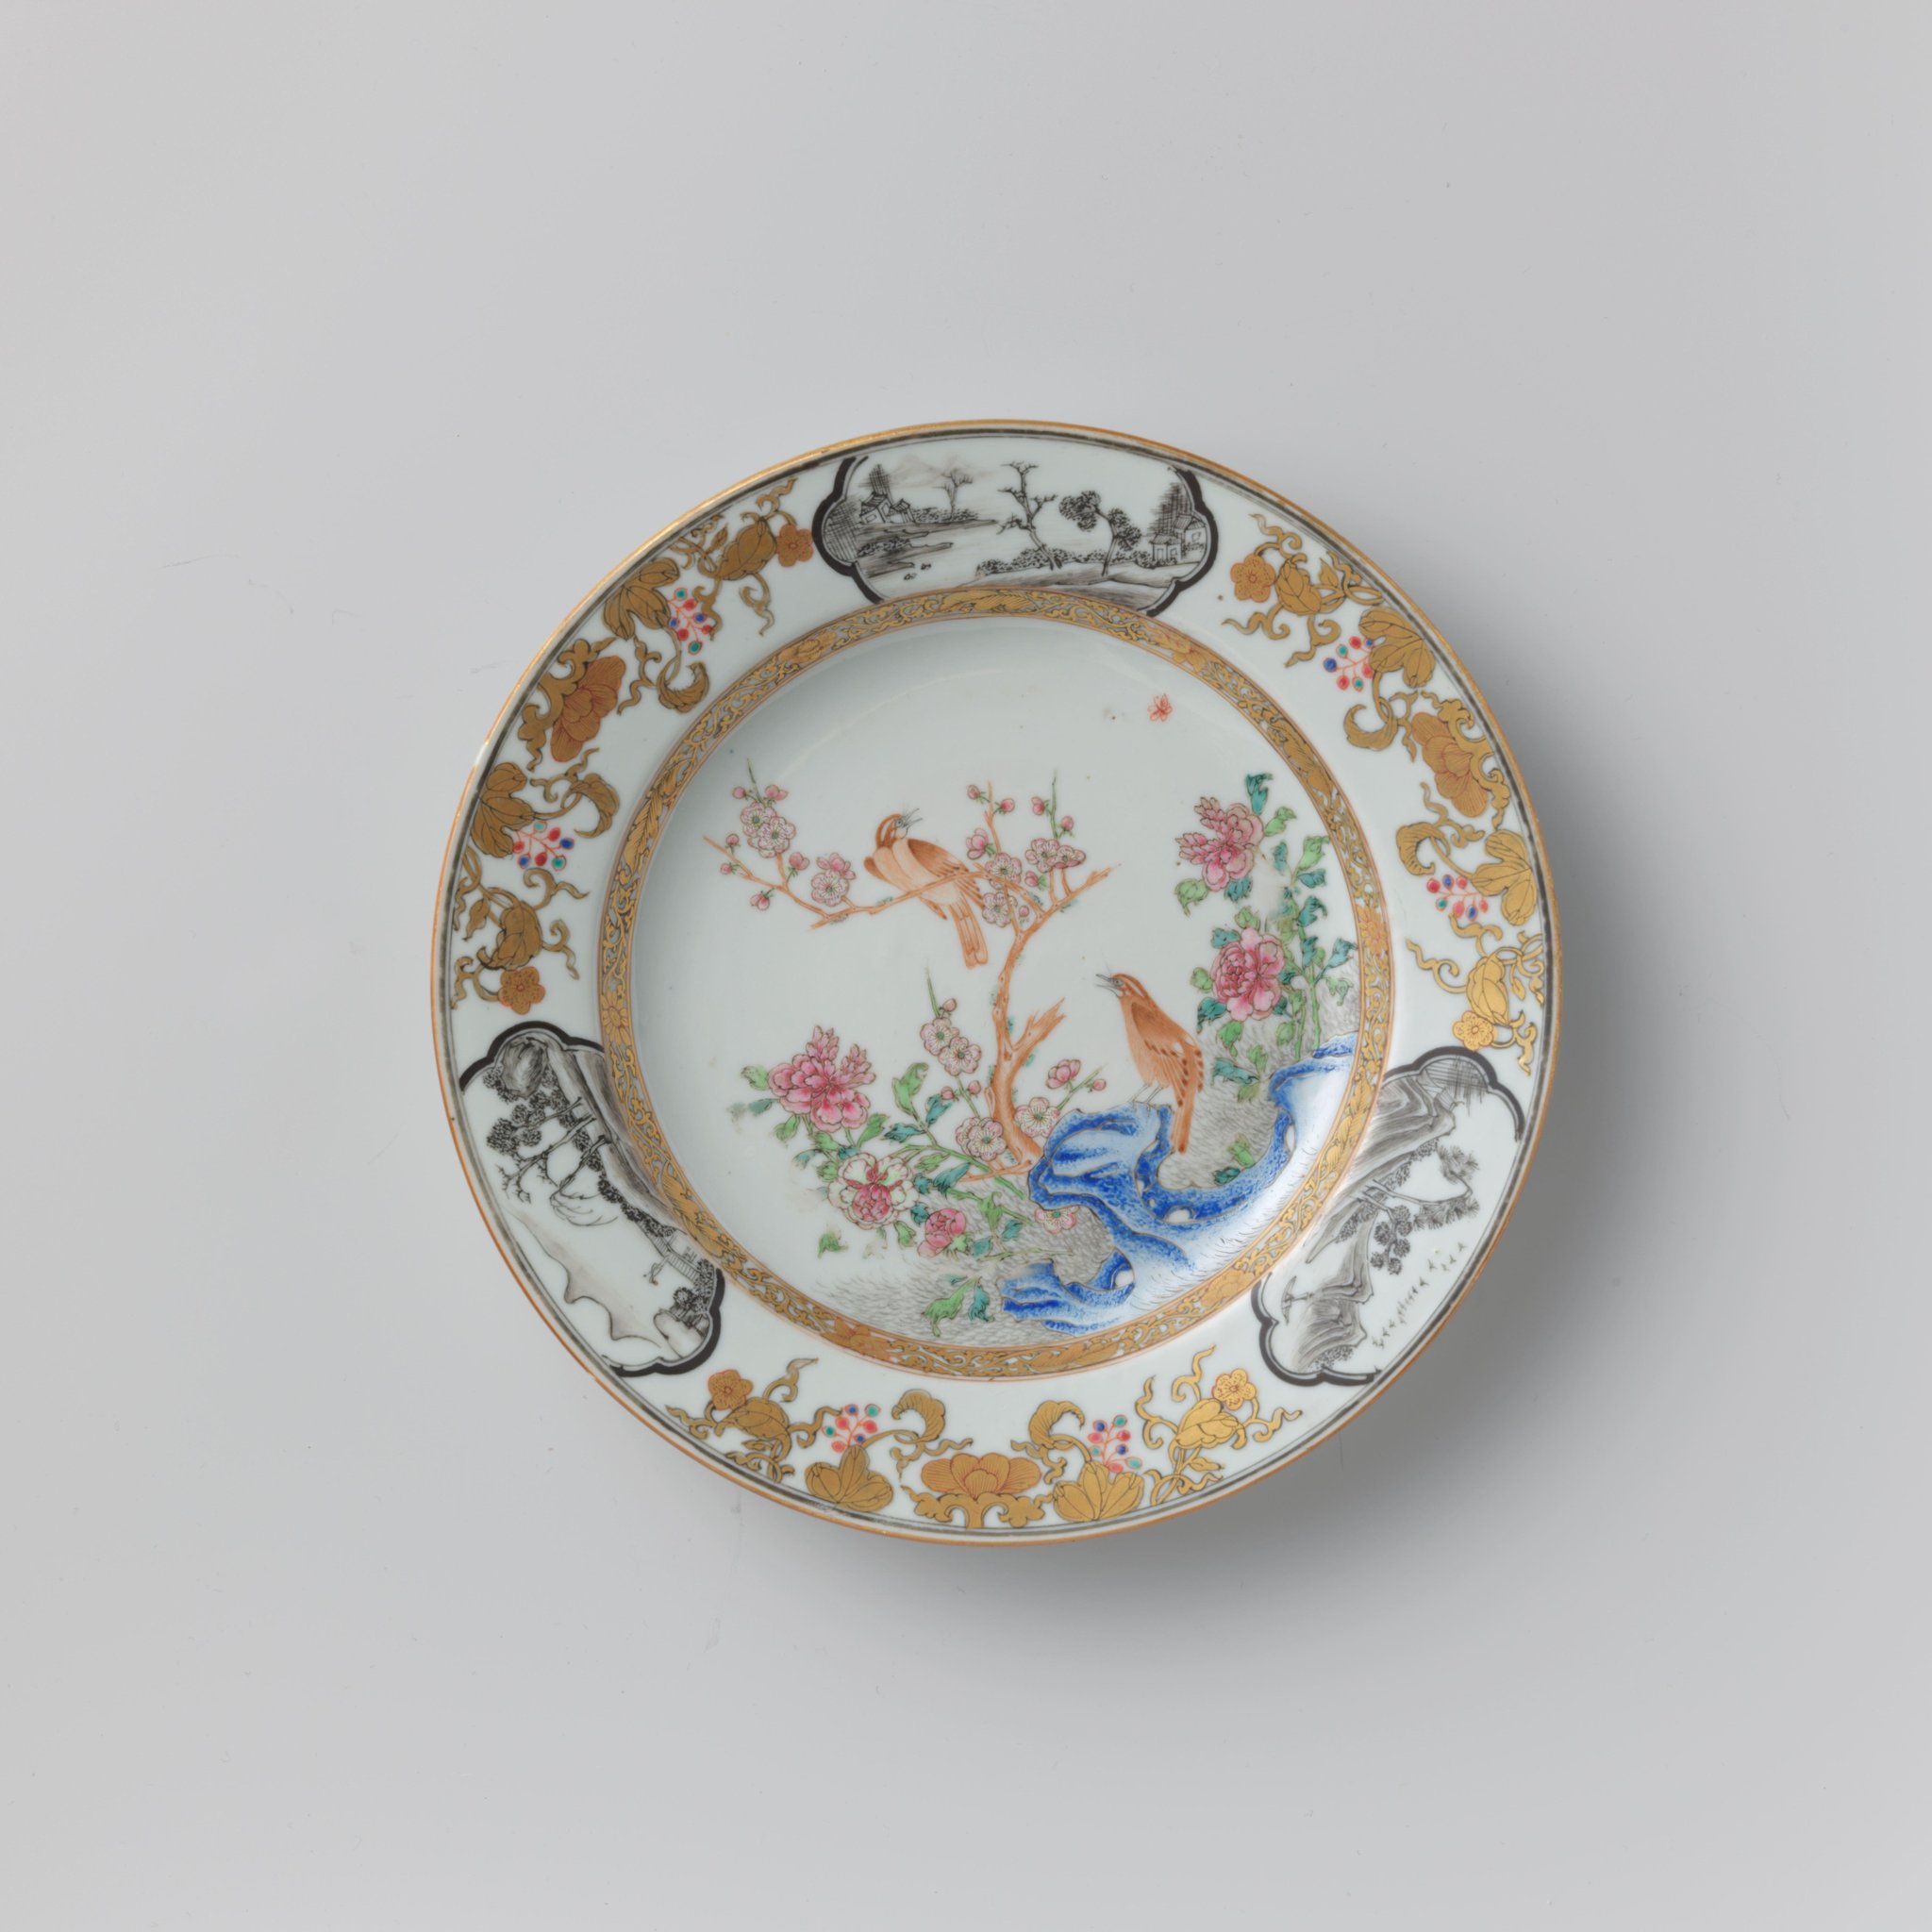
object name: plate dish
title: Plate with two birds on a rock with flowering plants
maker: Anonymous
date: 1725-1749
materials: glaze, gold, paint, porcelain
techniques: firing, gilding, turning, vitrification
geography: china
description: Bord, versierd in kleuren met vogels in een landschap, rand met goud en zwarte perken.